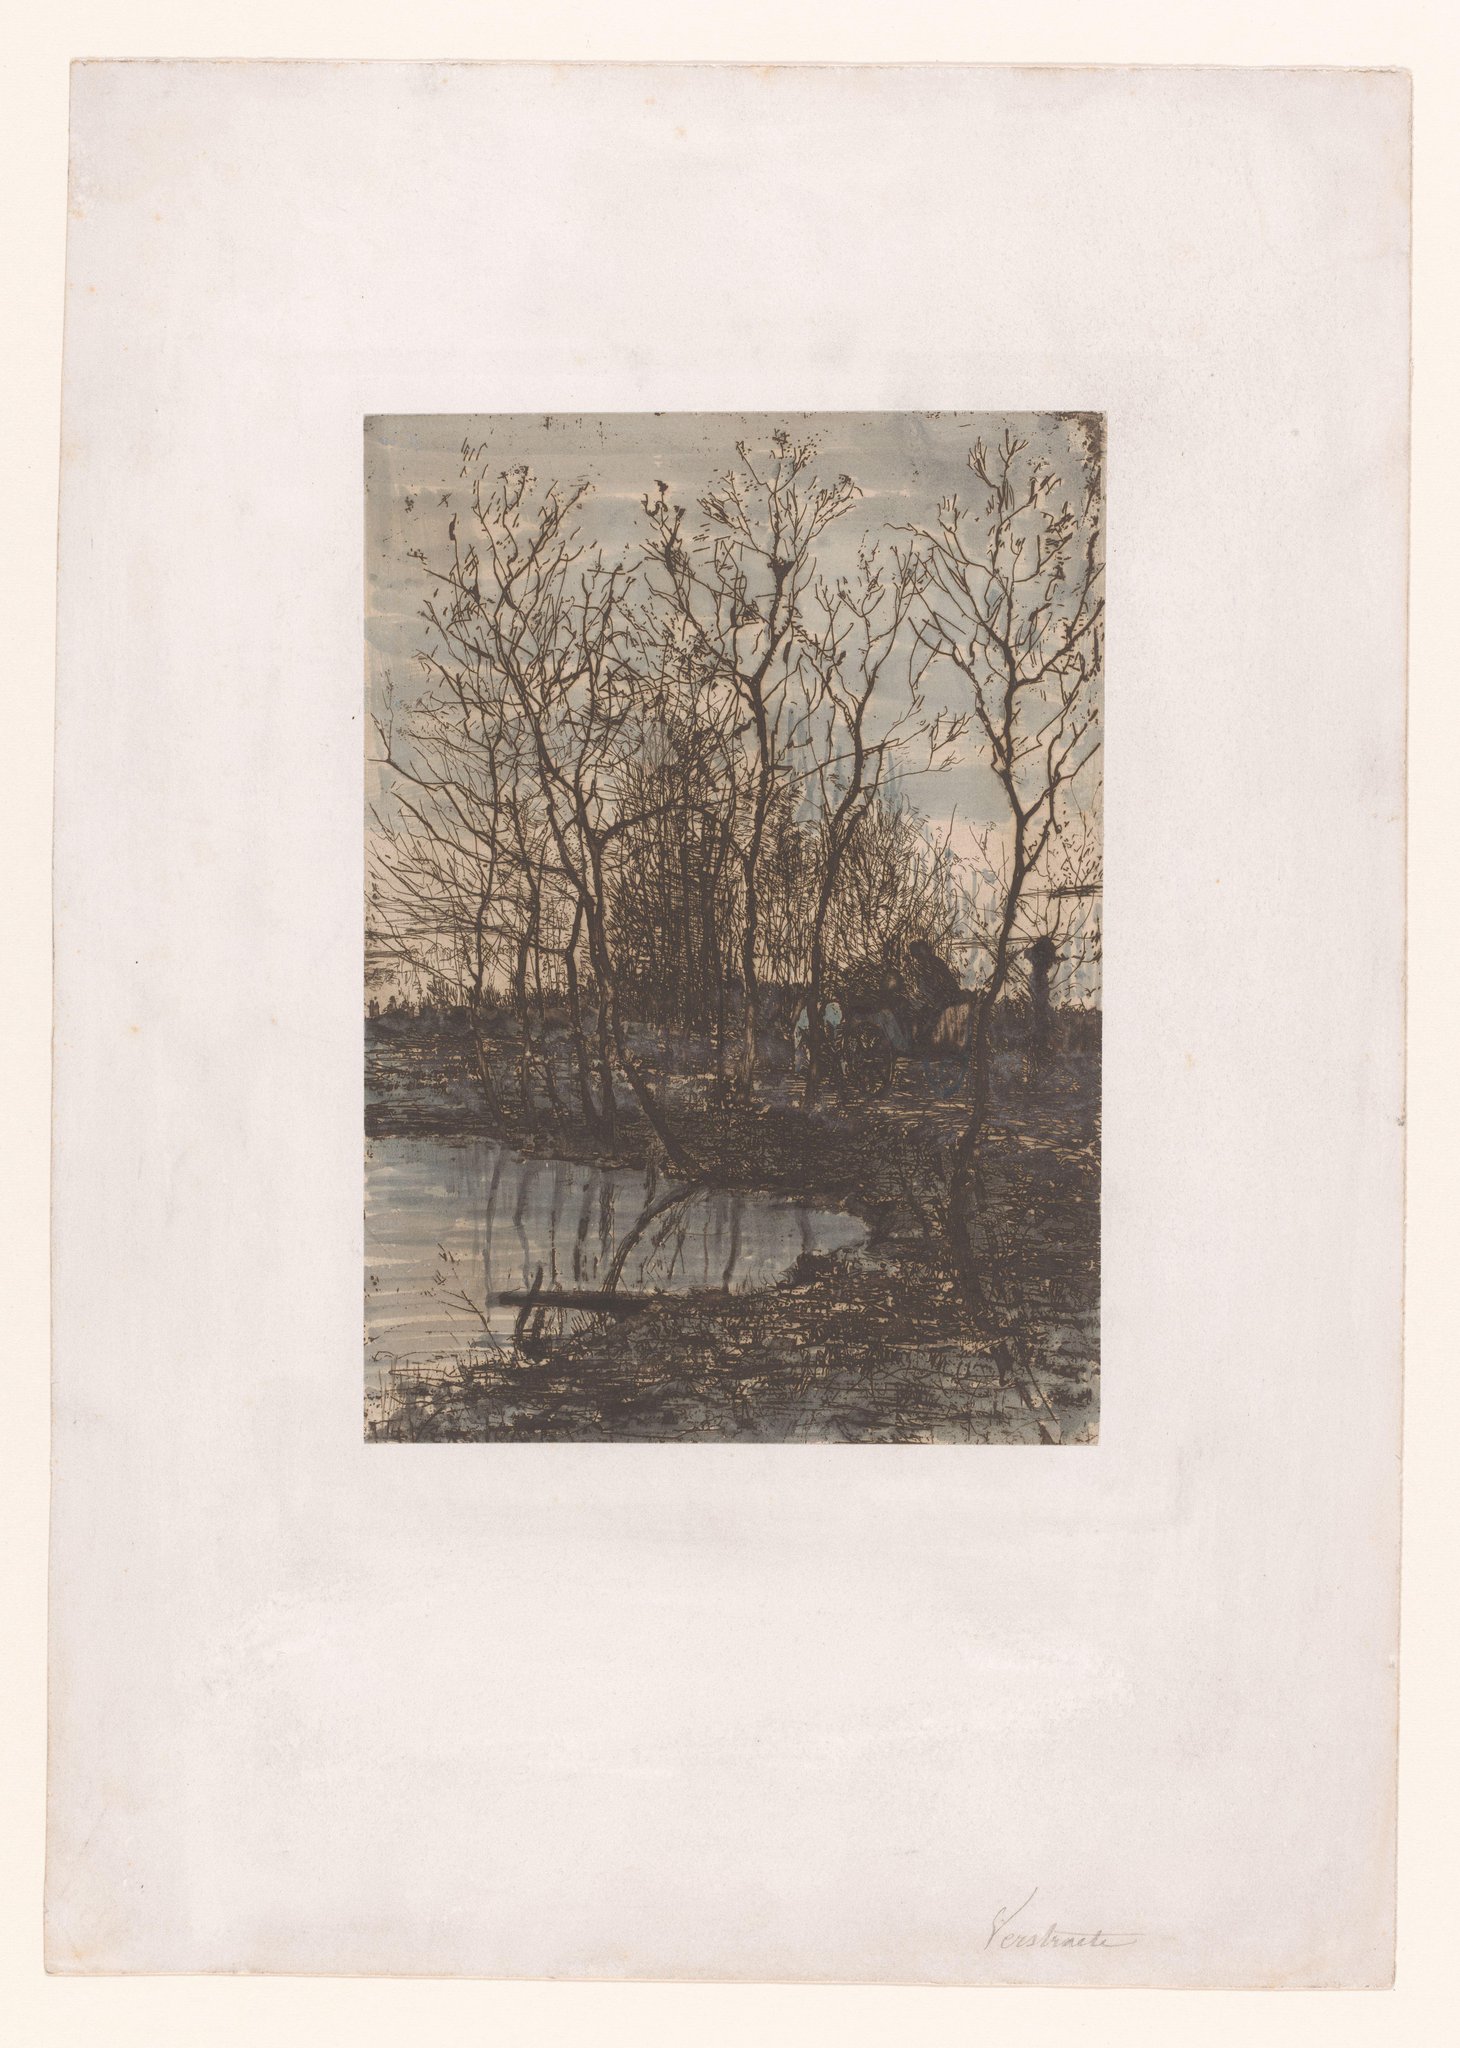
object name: print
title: Landscape at Night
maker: theodoor verstraete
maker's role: painter, print maker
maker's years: 1850-1907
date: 1880-1907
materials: paper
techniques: etching, hand coloring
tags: landscapes, night ~ landscape (sometimes titled 'nox')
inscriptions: collector's mark: Lugt 2228